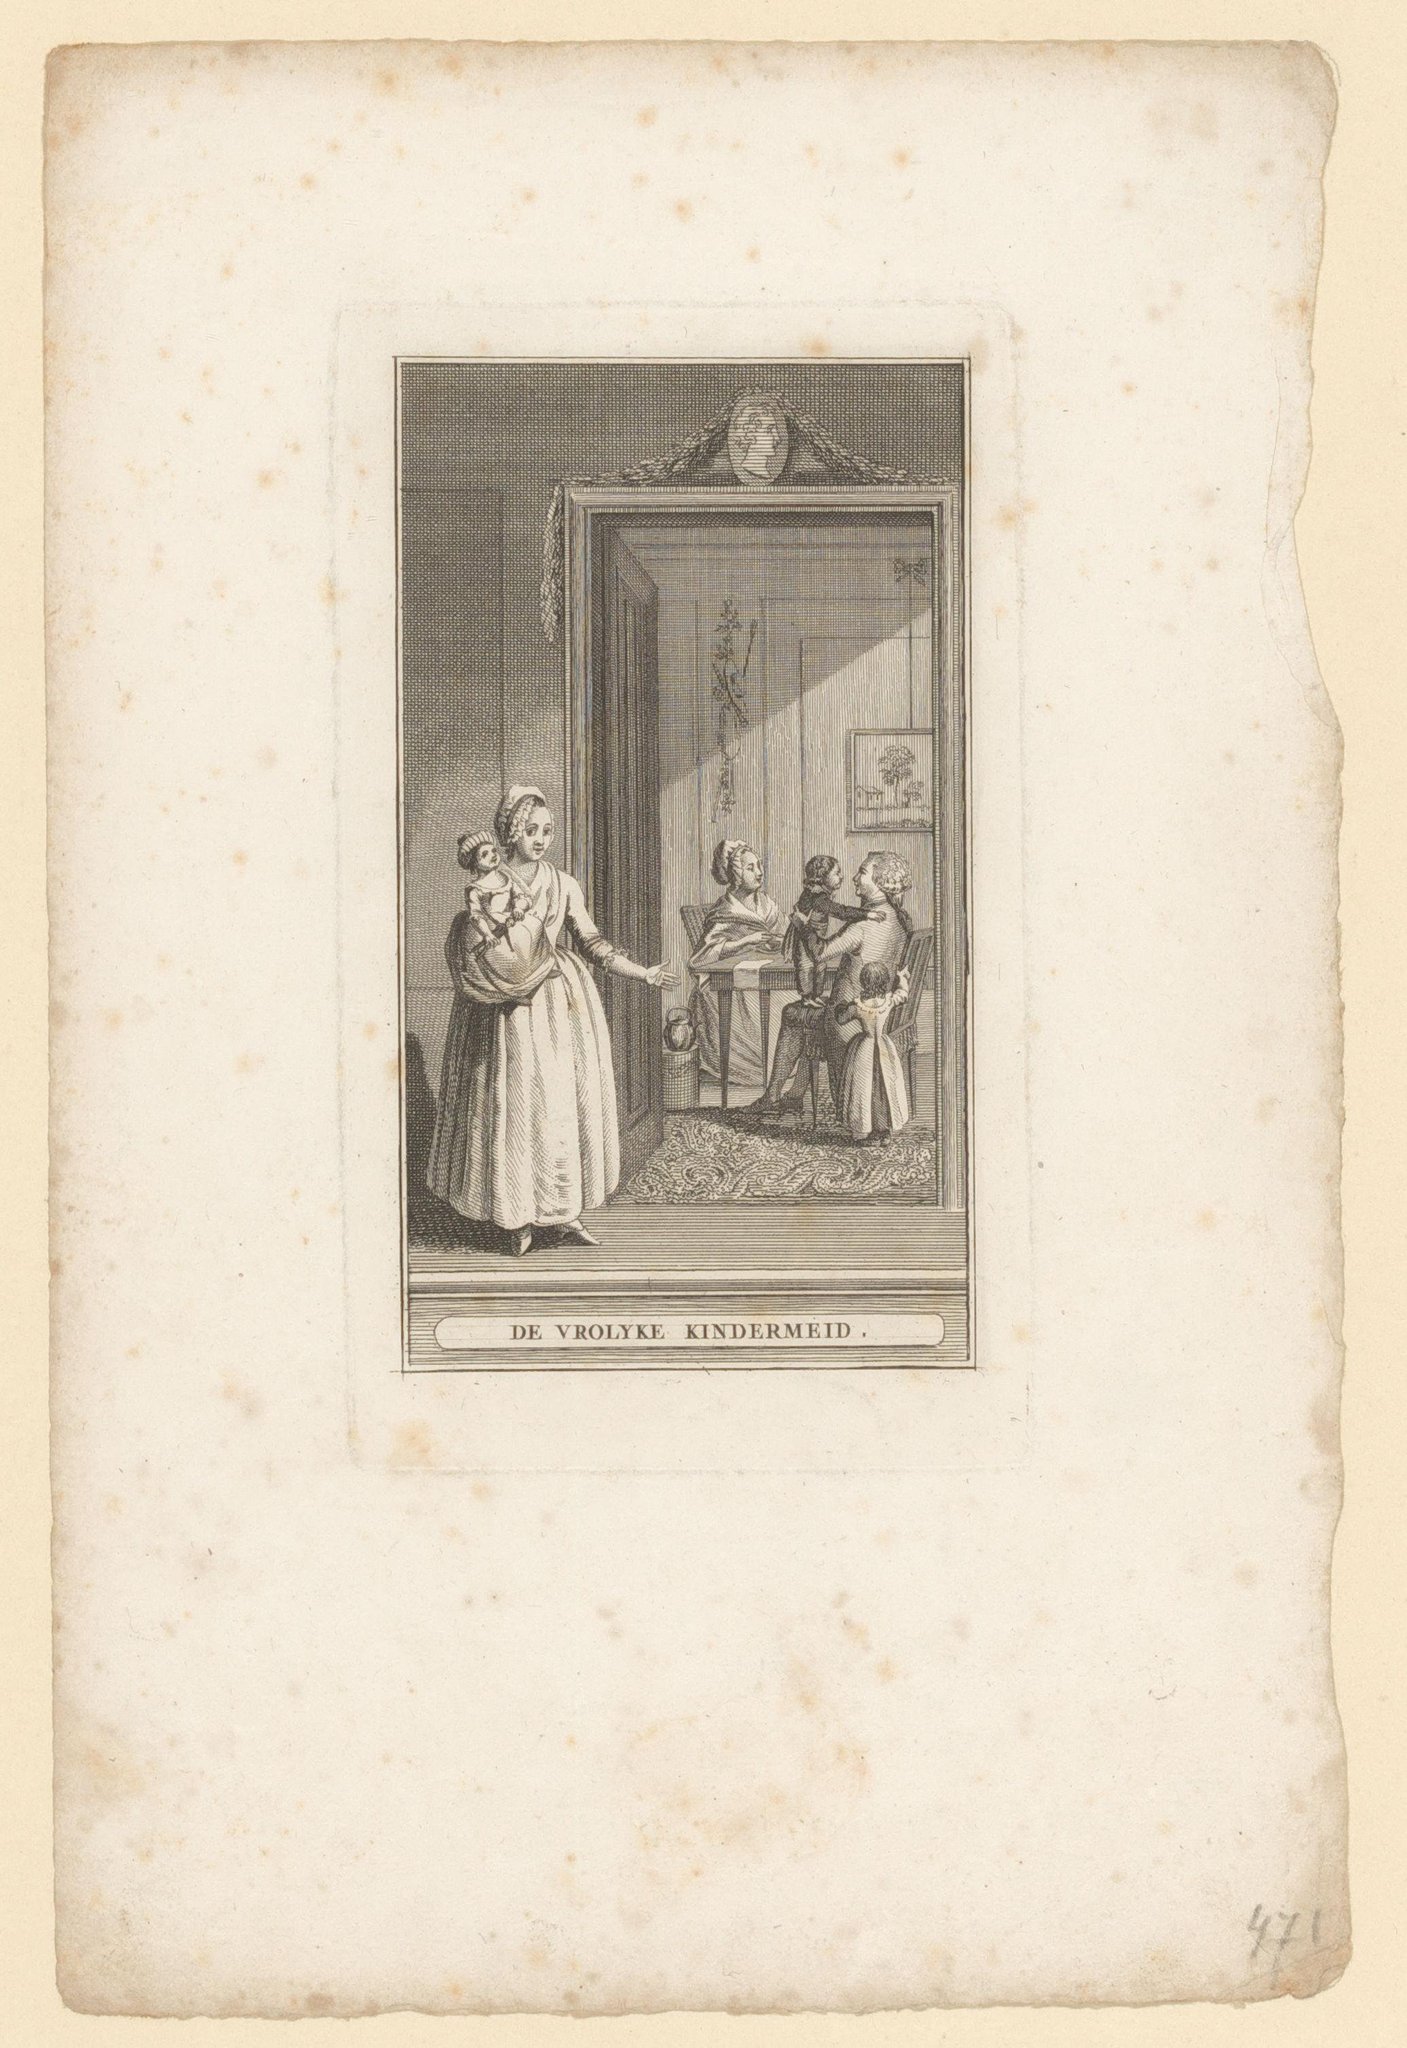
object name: print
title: De vrolyke kindermeid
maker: Anonymous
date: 1792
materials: paper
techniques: engraving, etching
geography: netherlands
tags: baby-sitter, family group, especially parents with their child(ren)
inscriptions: collector's mark, collector's mark: Lugt 1641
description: In een gang staat een kindermeid met een kindje op de arm dat een popje vasthoudt. In de kamer een man en een vrouw met twee kinderen aan tafel. Onderwerpsrubrieken binnen de Atlas Zeden en Gewoonten: Beroep en bedrijf. Vrouwelijk beroep en bedrijf. Dienstboden.